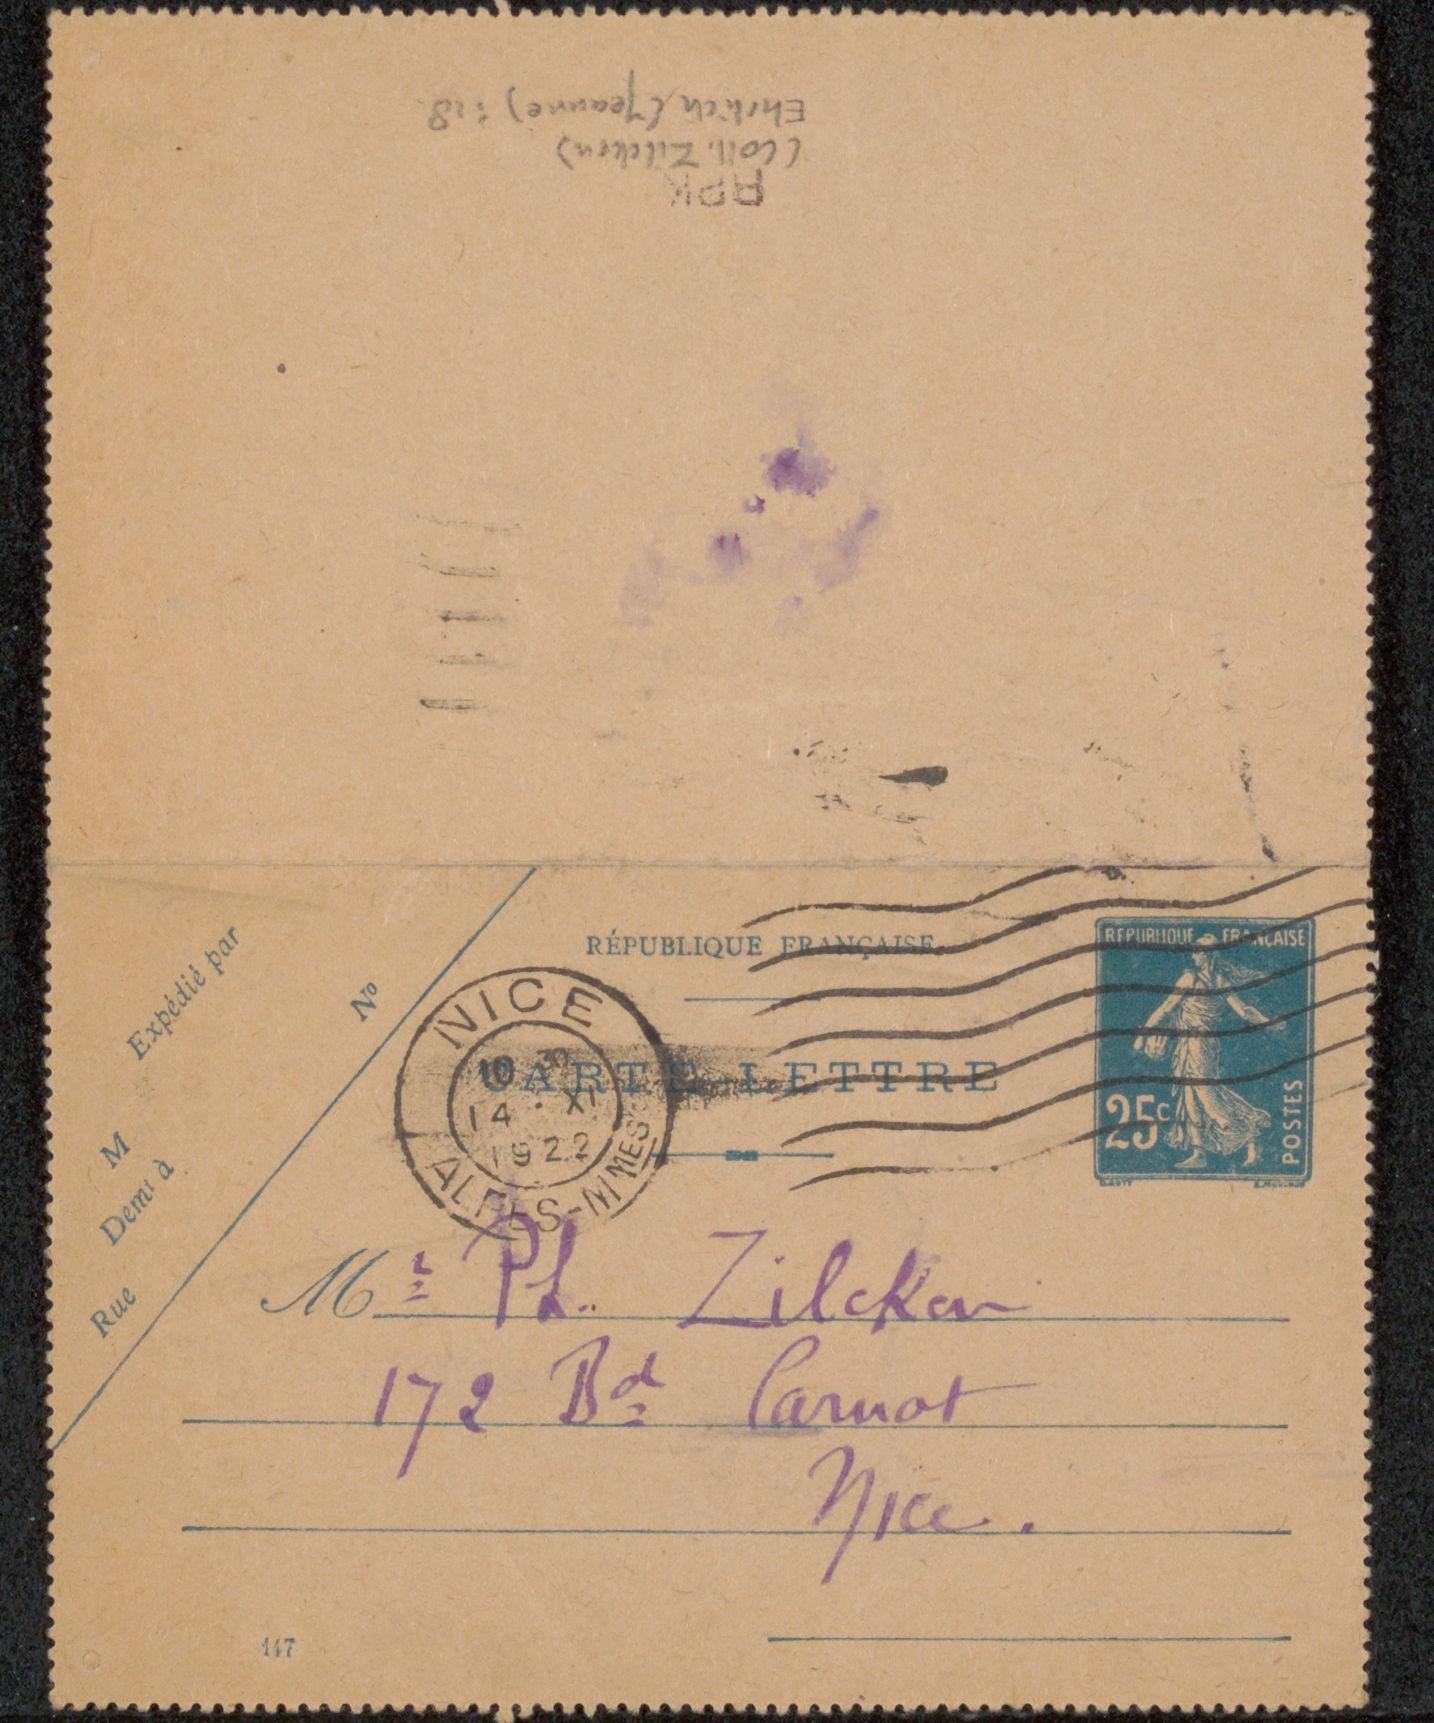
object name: postcard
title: Briefkaart aan Philip Zilcken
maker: jeanne erlich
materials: ink, paper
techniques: pen, writing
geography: nice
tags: the hague, painter, draughtsman, philip zilcken, literature ~ arts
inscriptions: collector's mark: ‘RPK’